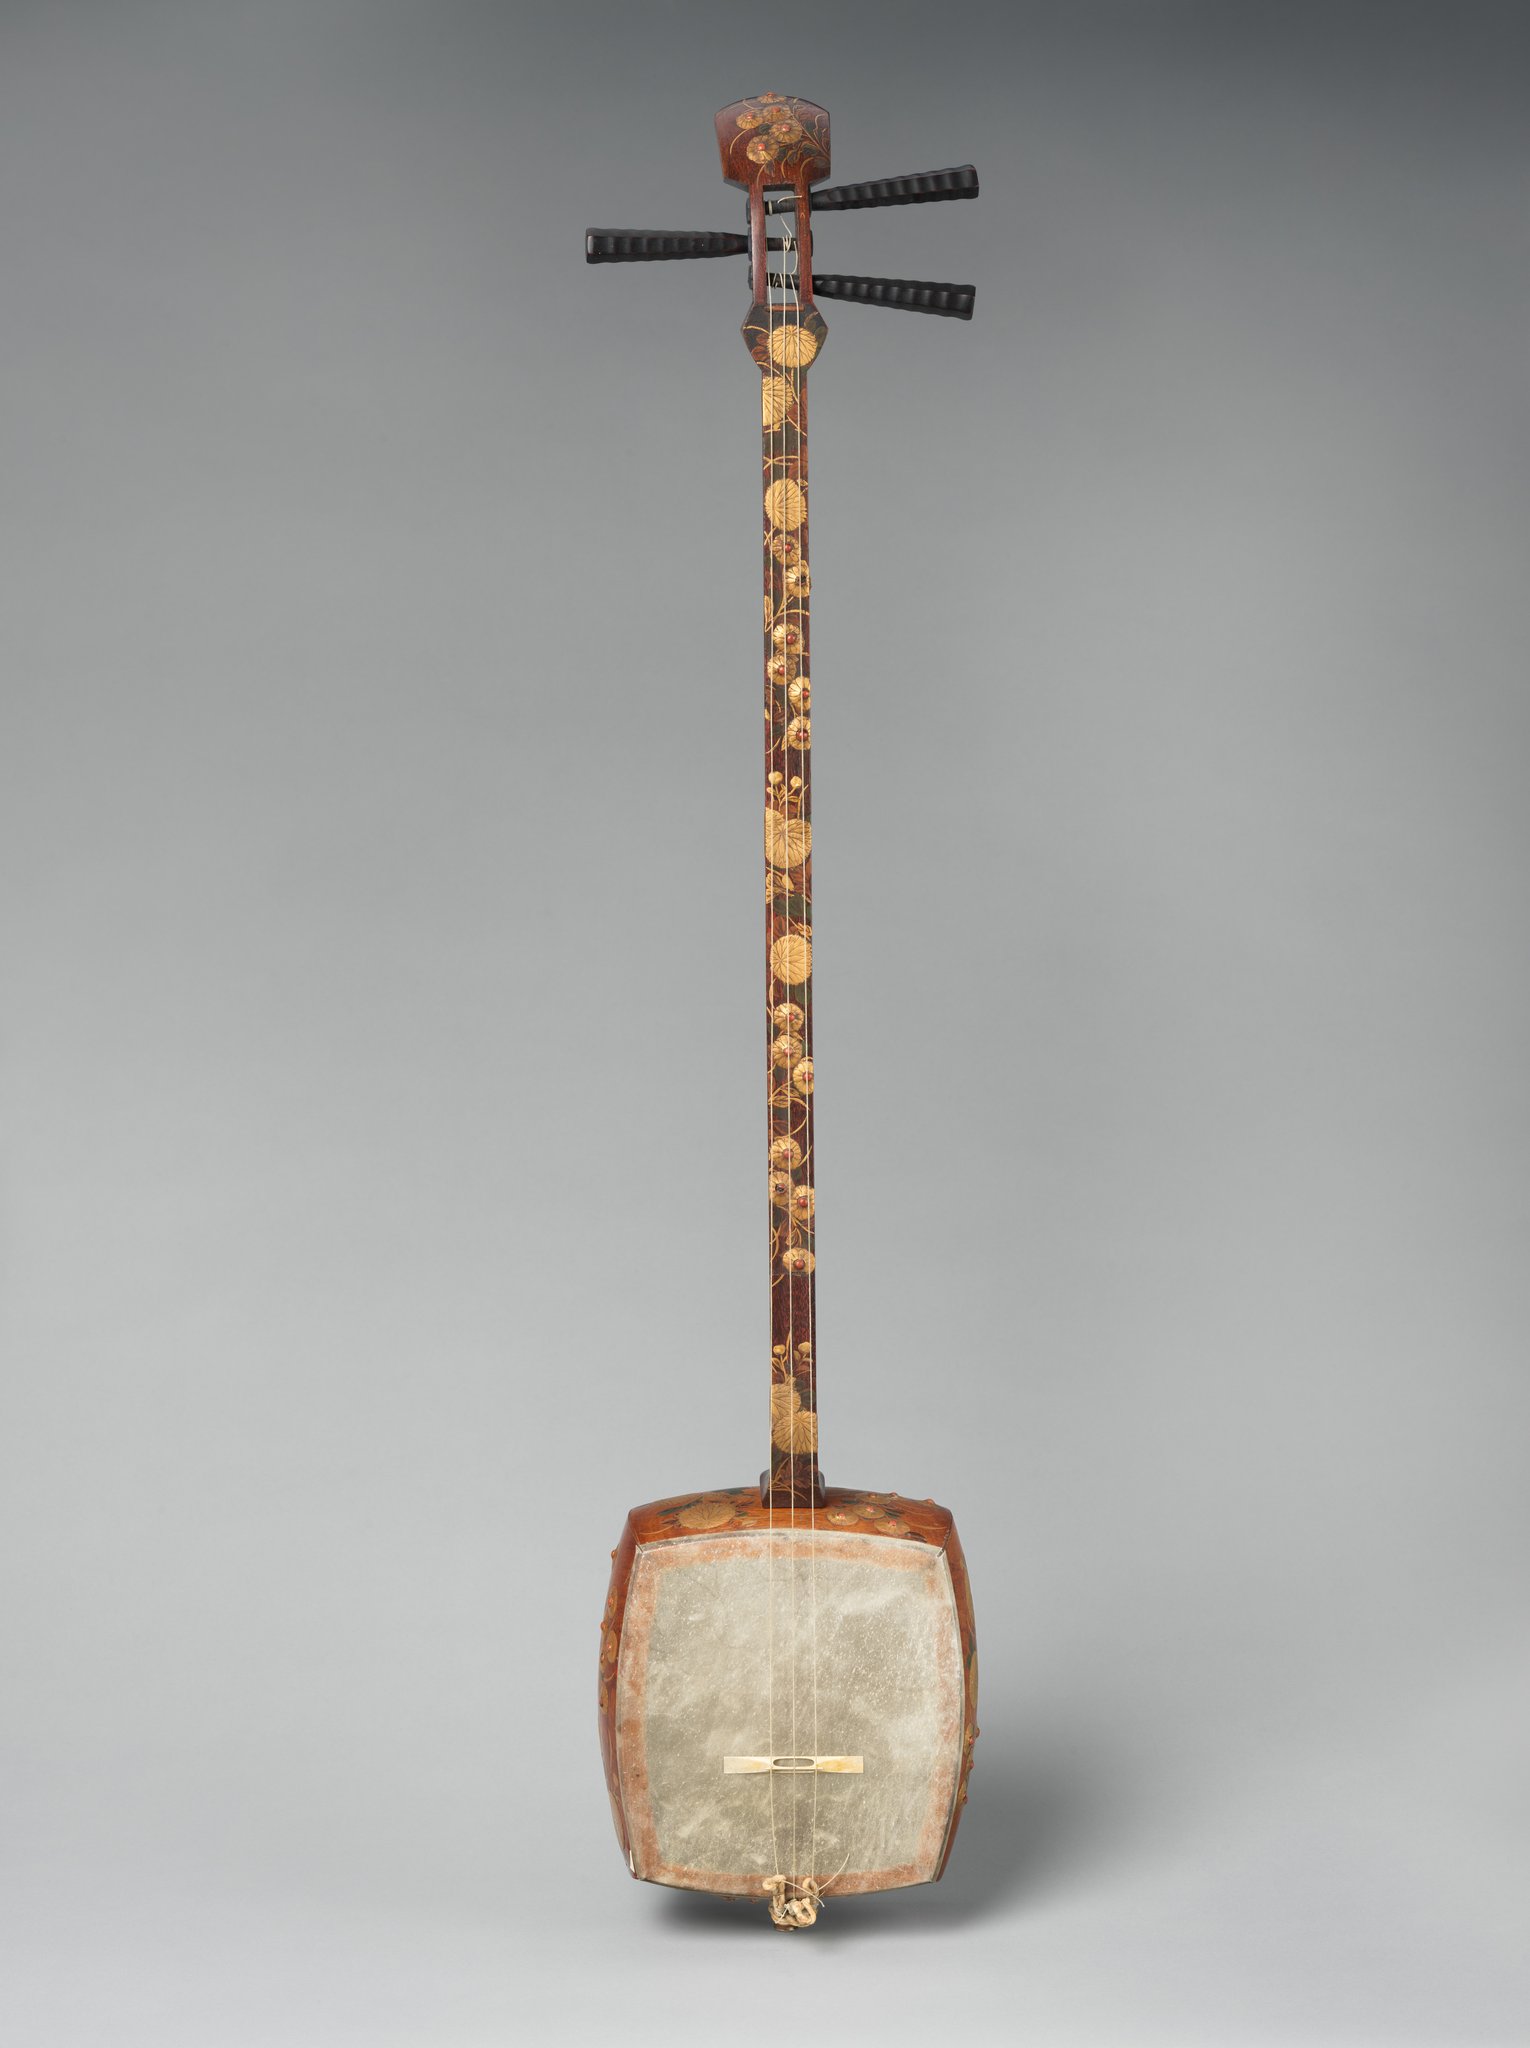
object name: shamisen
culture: japanese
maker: takechi matsukawa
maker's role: maker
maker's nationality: japanese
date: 1891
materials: coral, lacquer, fiber, silk, wood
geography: japan